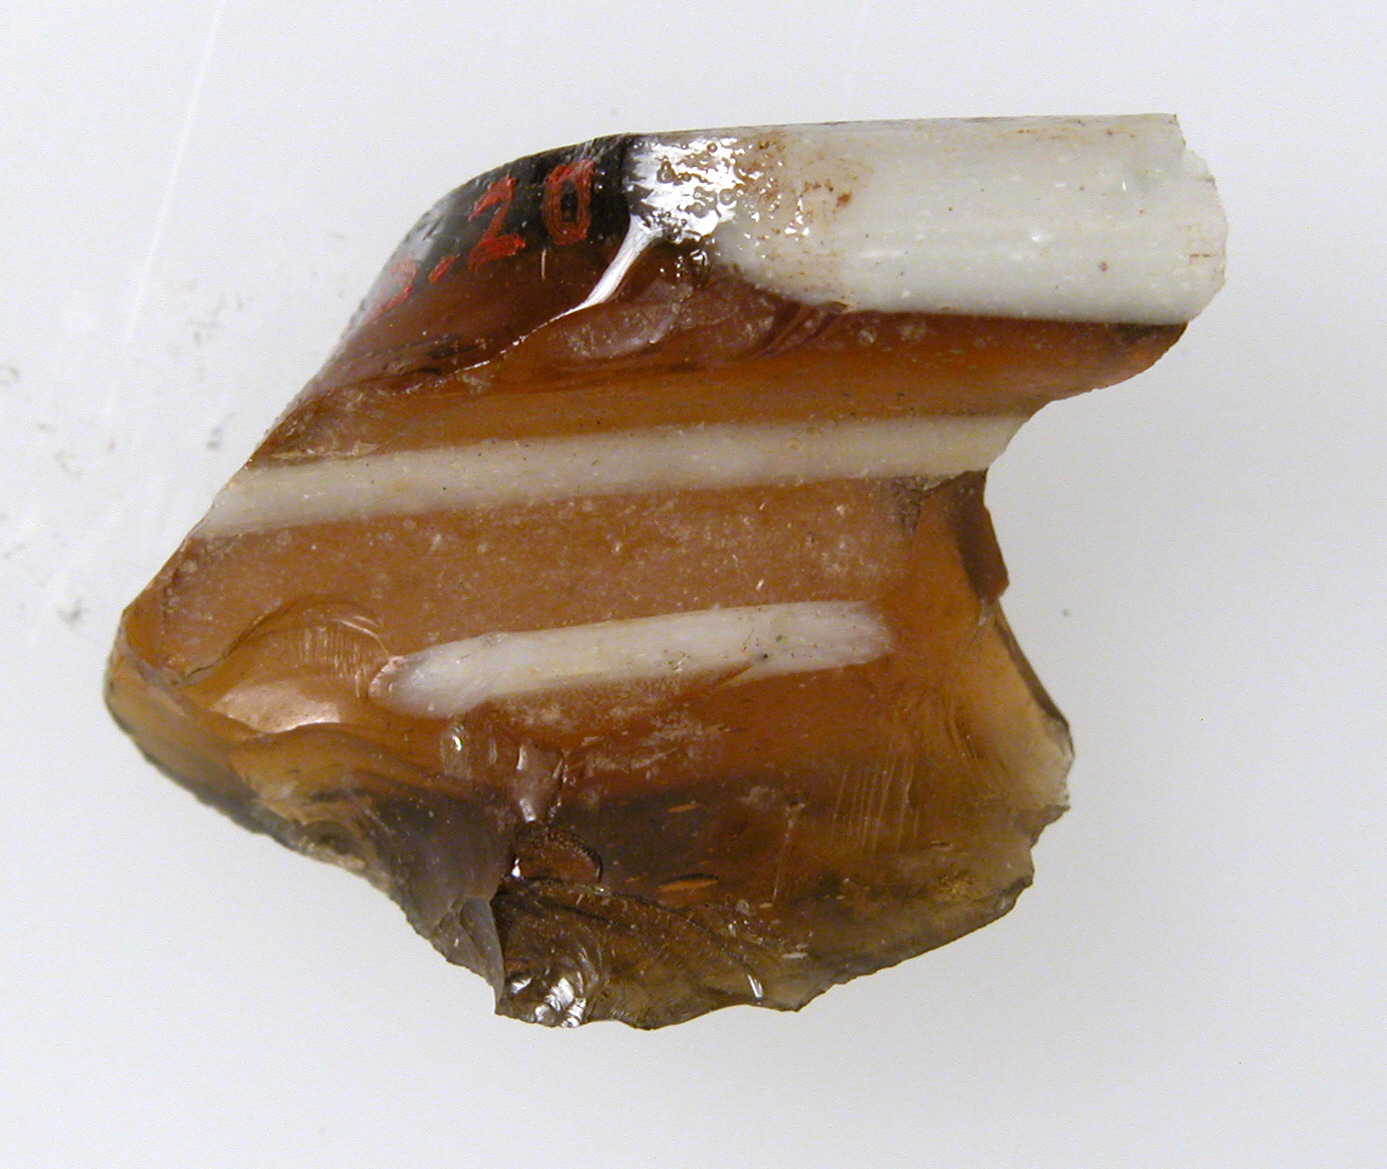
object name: fragment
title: Glass Fragment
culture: coptic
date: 301-433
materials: glass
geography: egypt